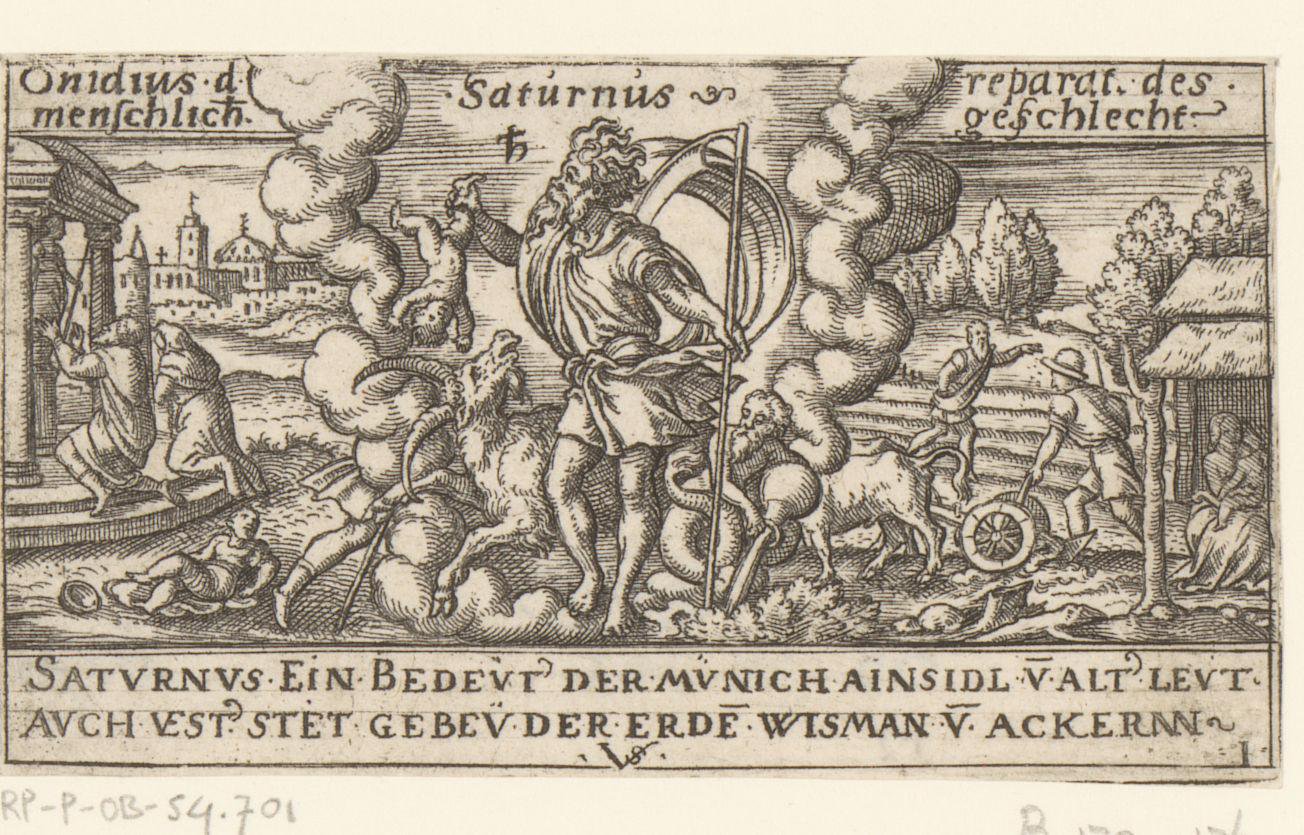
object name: print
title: Saturnus met een Steenbok en Waterman (tekens van de dierenriem)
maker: virgilius solis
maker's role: draughtsman, print maker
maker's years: 1514-1562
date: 1524-1562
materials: paper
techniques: engraving, etching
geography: nuremberg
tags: (story of) saturn (cronus), agriculture, aquarius (zodiacal sign of january), capricorn (zodiacal sign of december), saturn (planet)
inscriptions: collector's mark: Lugt 2228, number: ‘52’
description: Maakt deel uit van een serie van zeven prenten met personificaties van de planeten, tekens van de dierenriem en verbeeldingen van verhalen uit de Metamorfosen van Ovidius.